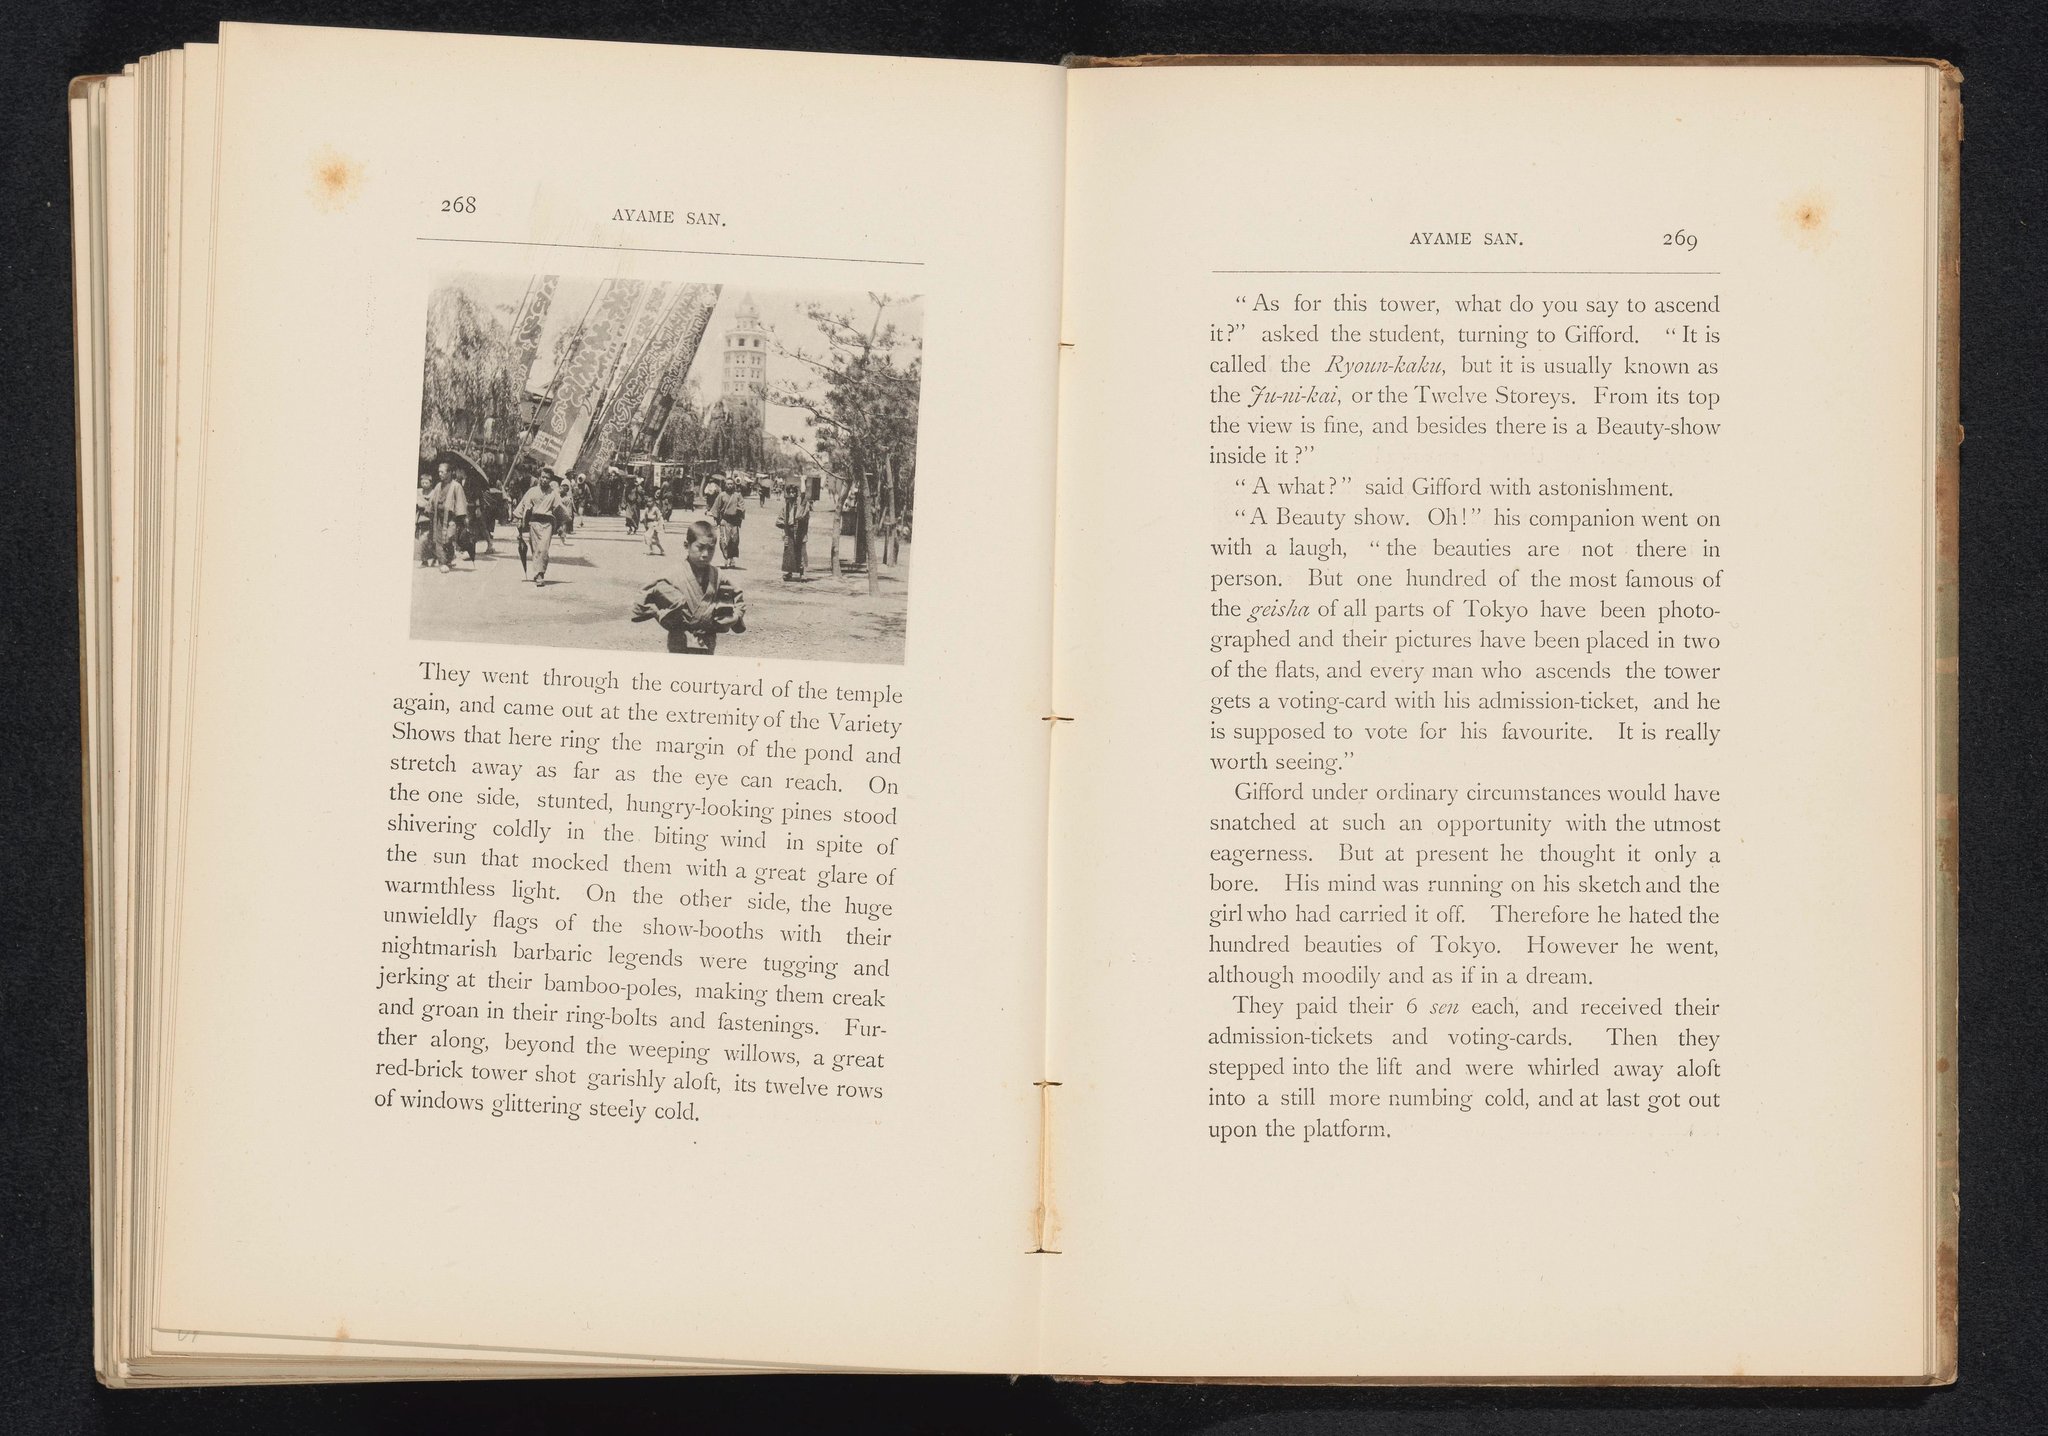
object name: photomechanical print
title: Gezicht op een straat (vermoedelijk) te Tokyo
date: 1882-1892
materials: paper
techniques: photograph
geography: tokyo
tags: street